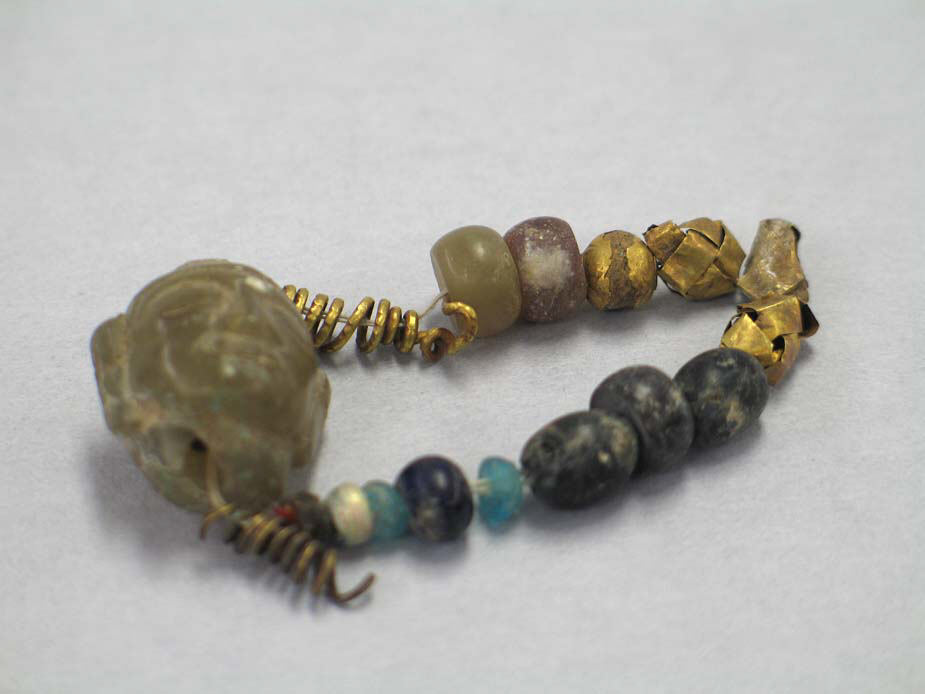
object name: bracelet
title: Bracelet with Male Head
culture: thai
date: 1501-1800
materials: glass, gold, stone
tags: heads,men